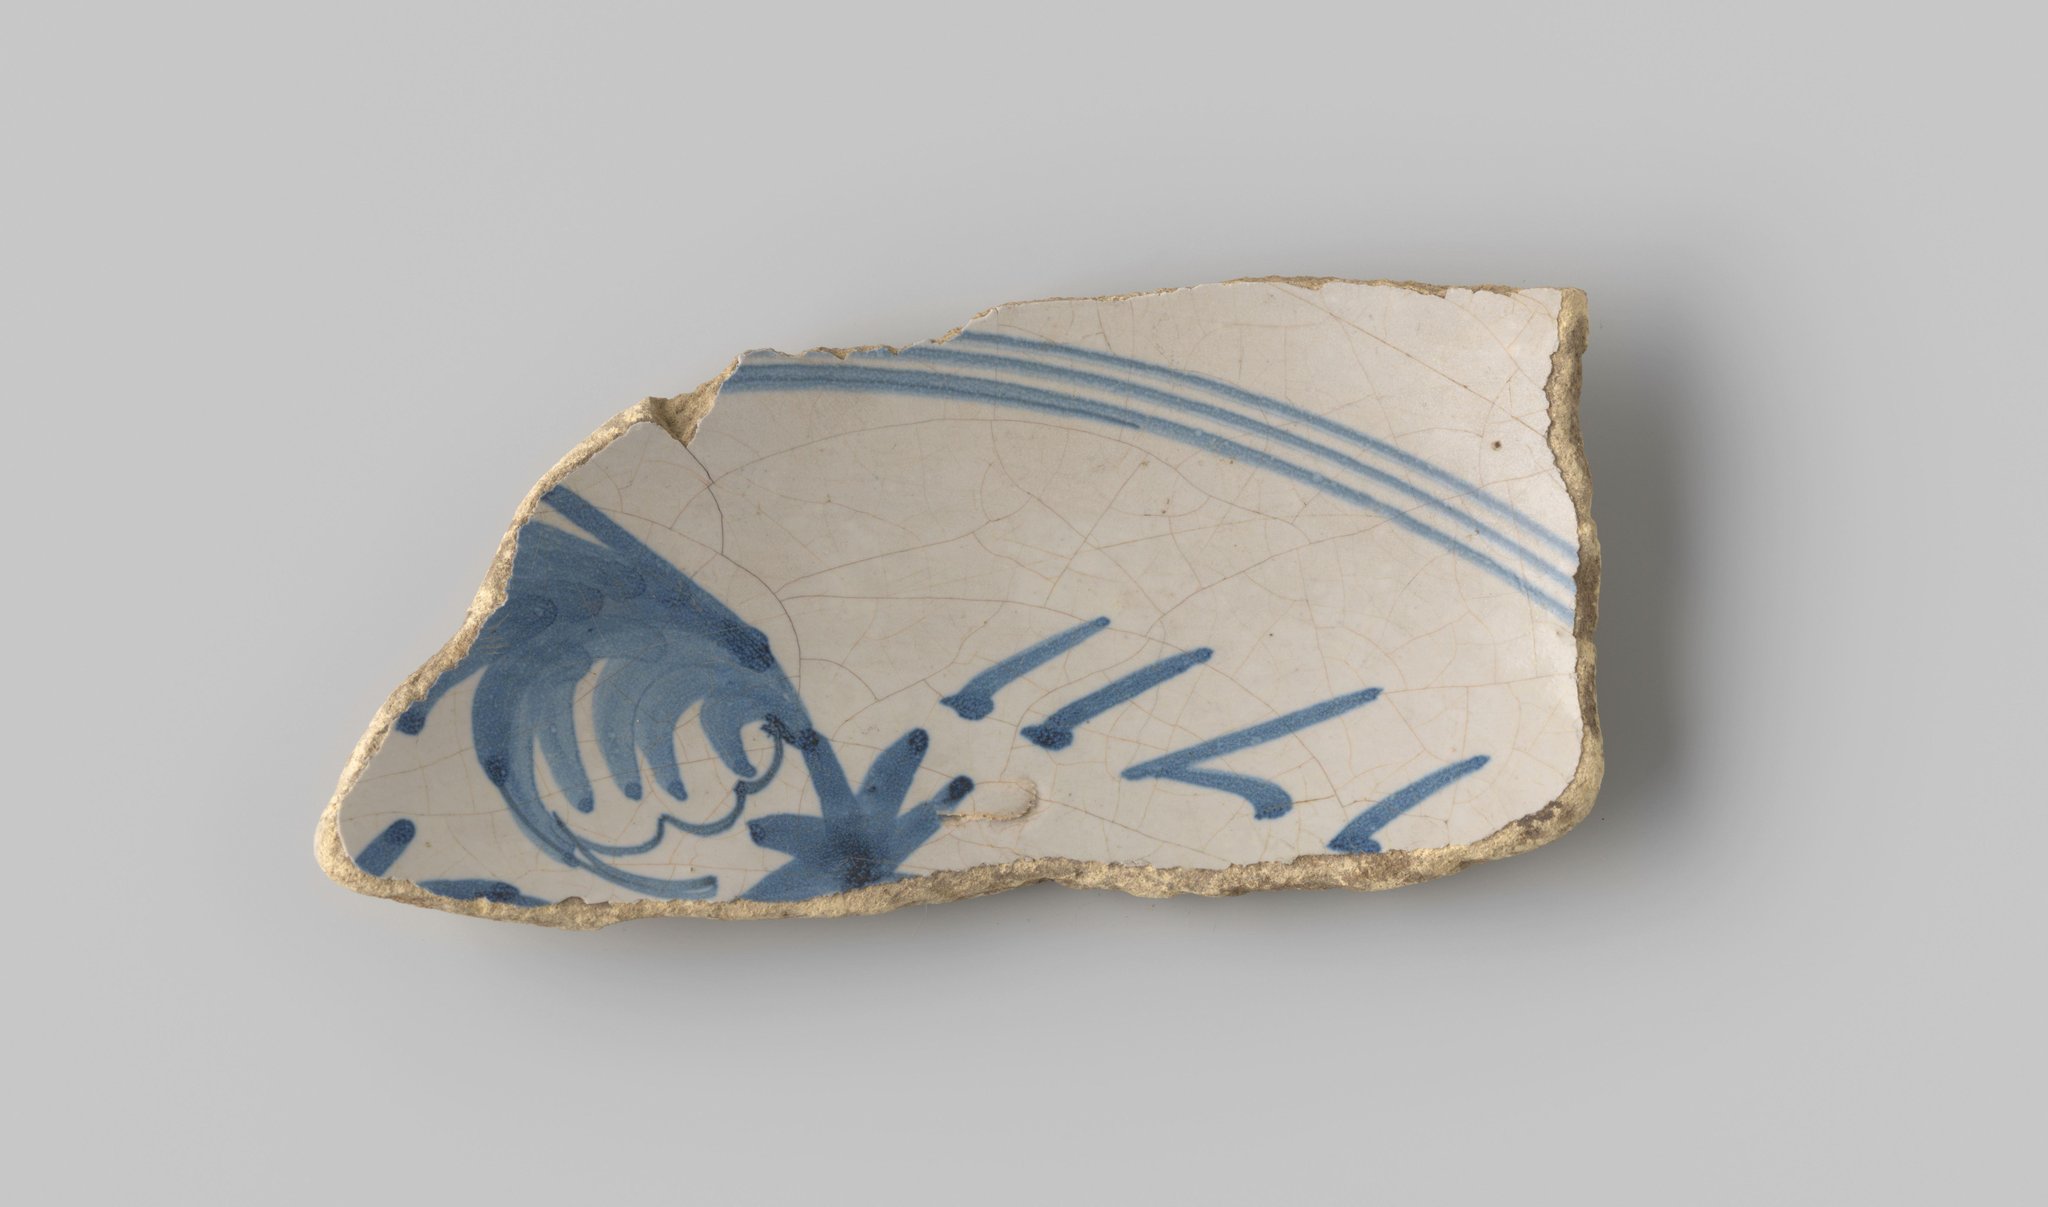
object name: platter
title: Fragment van een schotel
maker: Anonymous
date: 1711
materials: earthenware, glaze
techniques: maiolica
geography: northern netherlands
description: Fragment van een schotel. Crème scherf bedekt met tinglazuur aan de voorzijde en loodglazuur aan de achterzijde. Beschilderd in blauw met een blad (?) en het jaartal 1711.